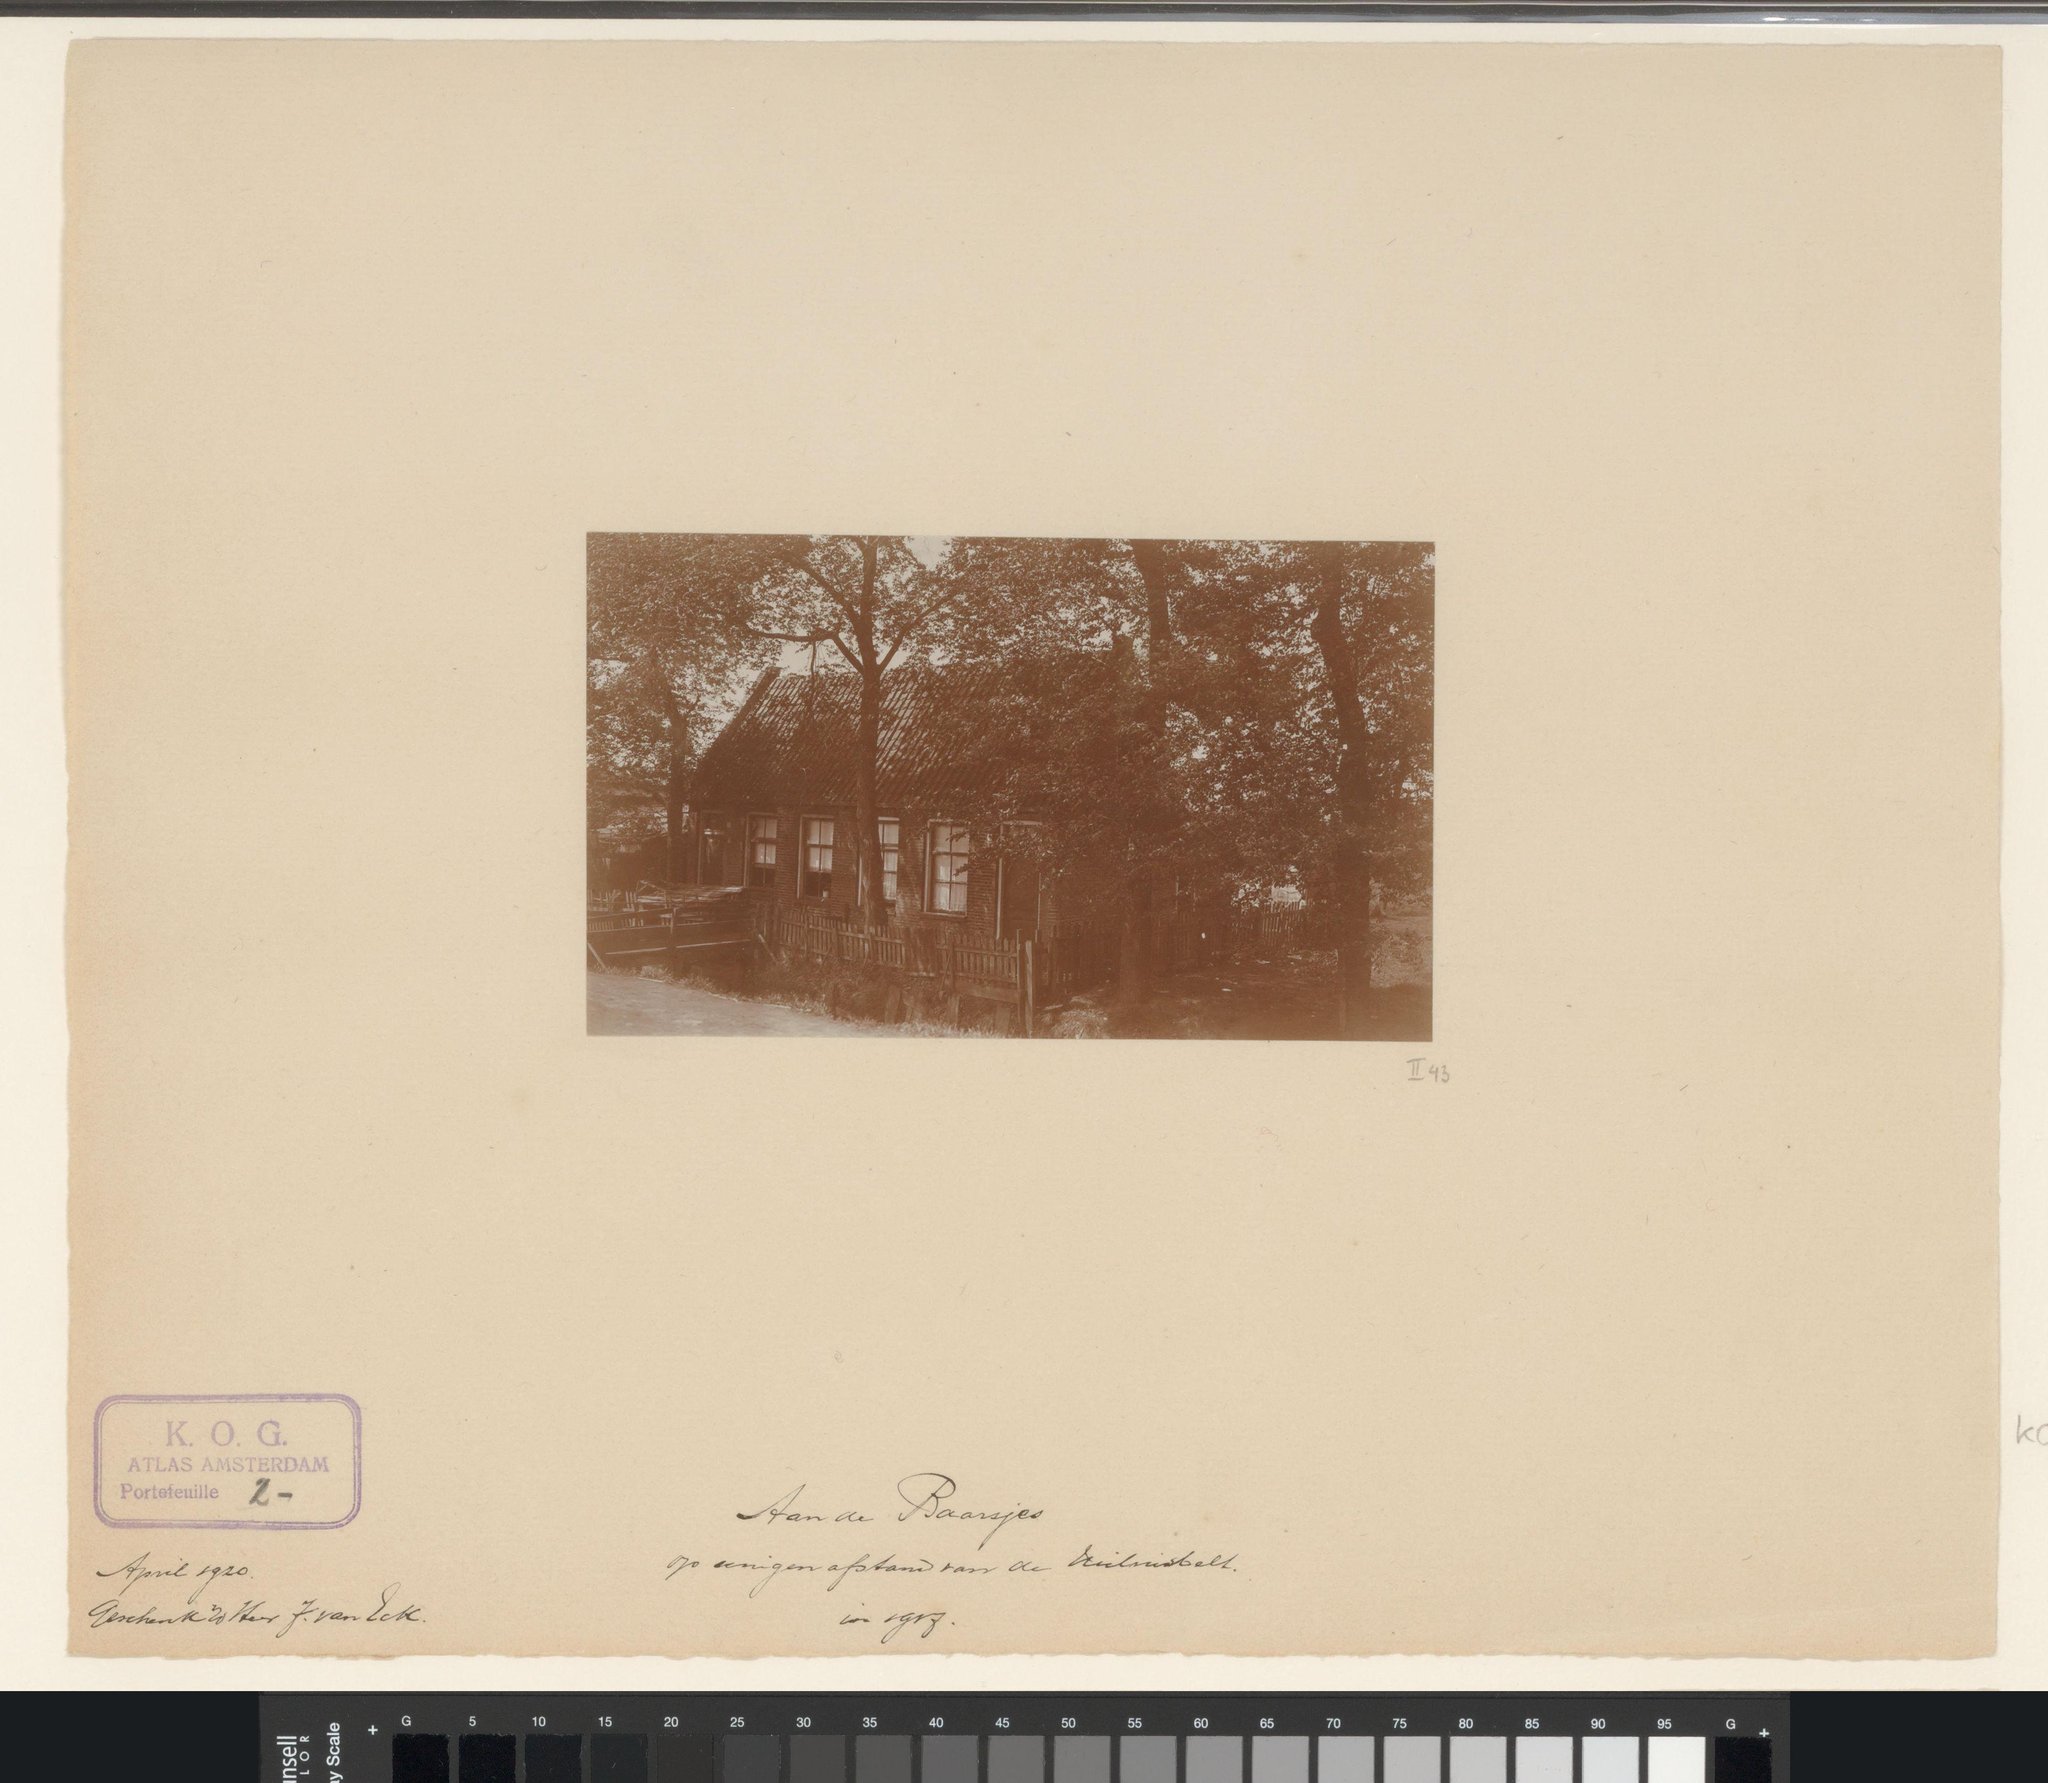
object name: photograph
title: Gezicht op een huis aan de Baarsjes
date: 1917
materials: paper, cardboard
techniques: gelatin silver print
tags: city-view in general; 'veduta', lane, alley, farm or solitary house in landscape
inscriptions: collector's mark: ‘2-’ Lugt 1641b, inscription: ‘April 1920 / Geschenk v/d Heer J. van Eck. / Aan de Baarsjes / op eenigen afstand van de vuilnisbelt / in 1917.’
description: Onderwerpsrubriek binnen de Atlas Amsterdam: Kostverloren Wetering.